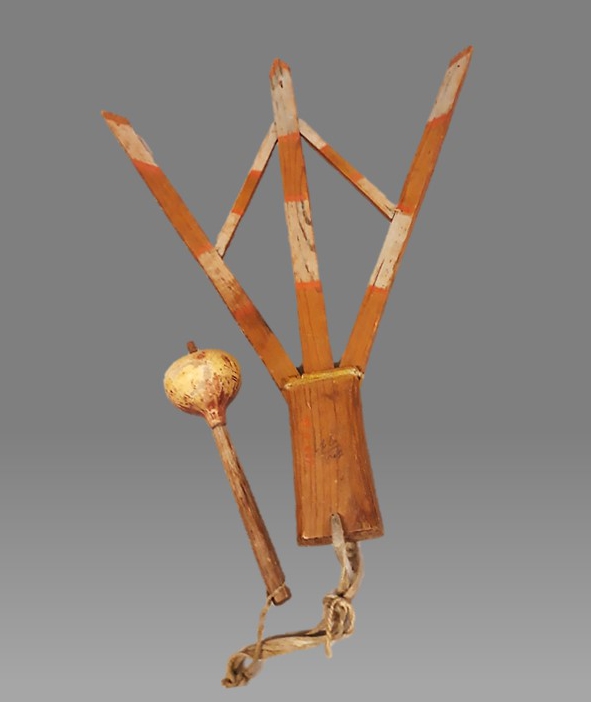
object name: trident palmas and rattle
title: Trident (palmas) and Rattle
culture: native american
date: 1801-1900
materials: wood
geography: united states